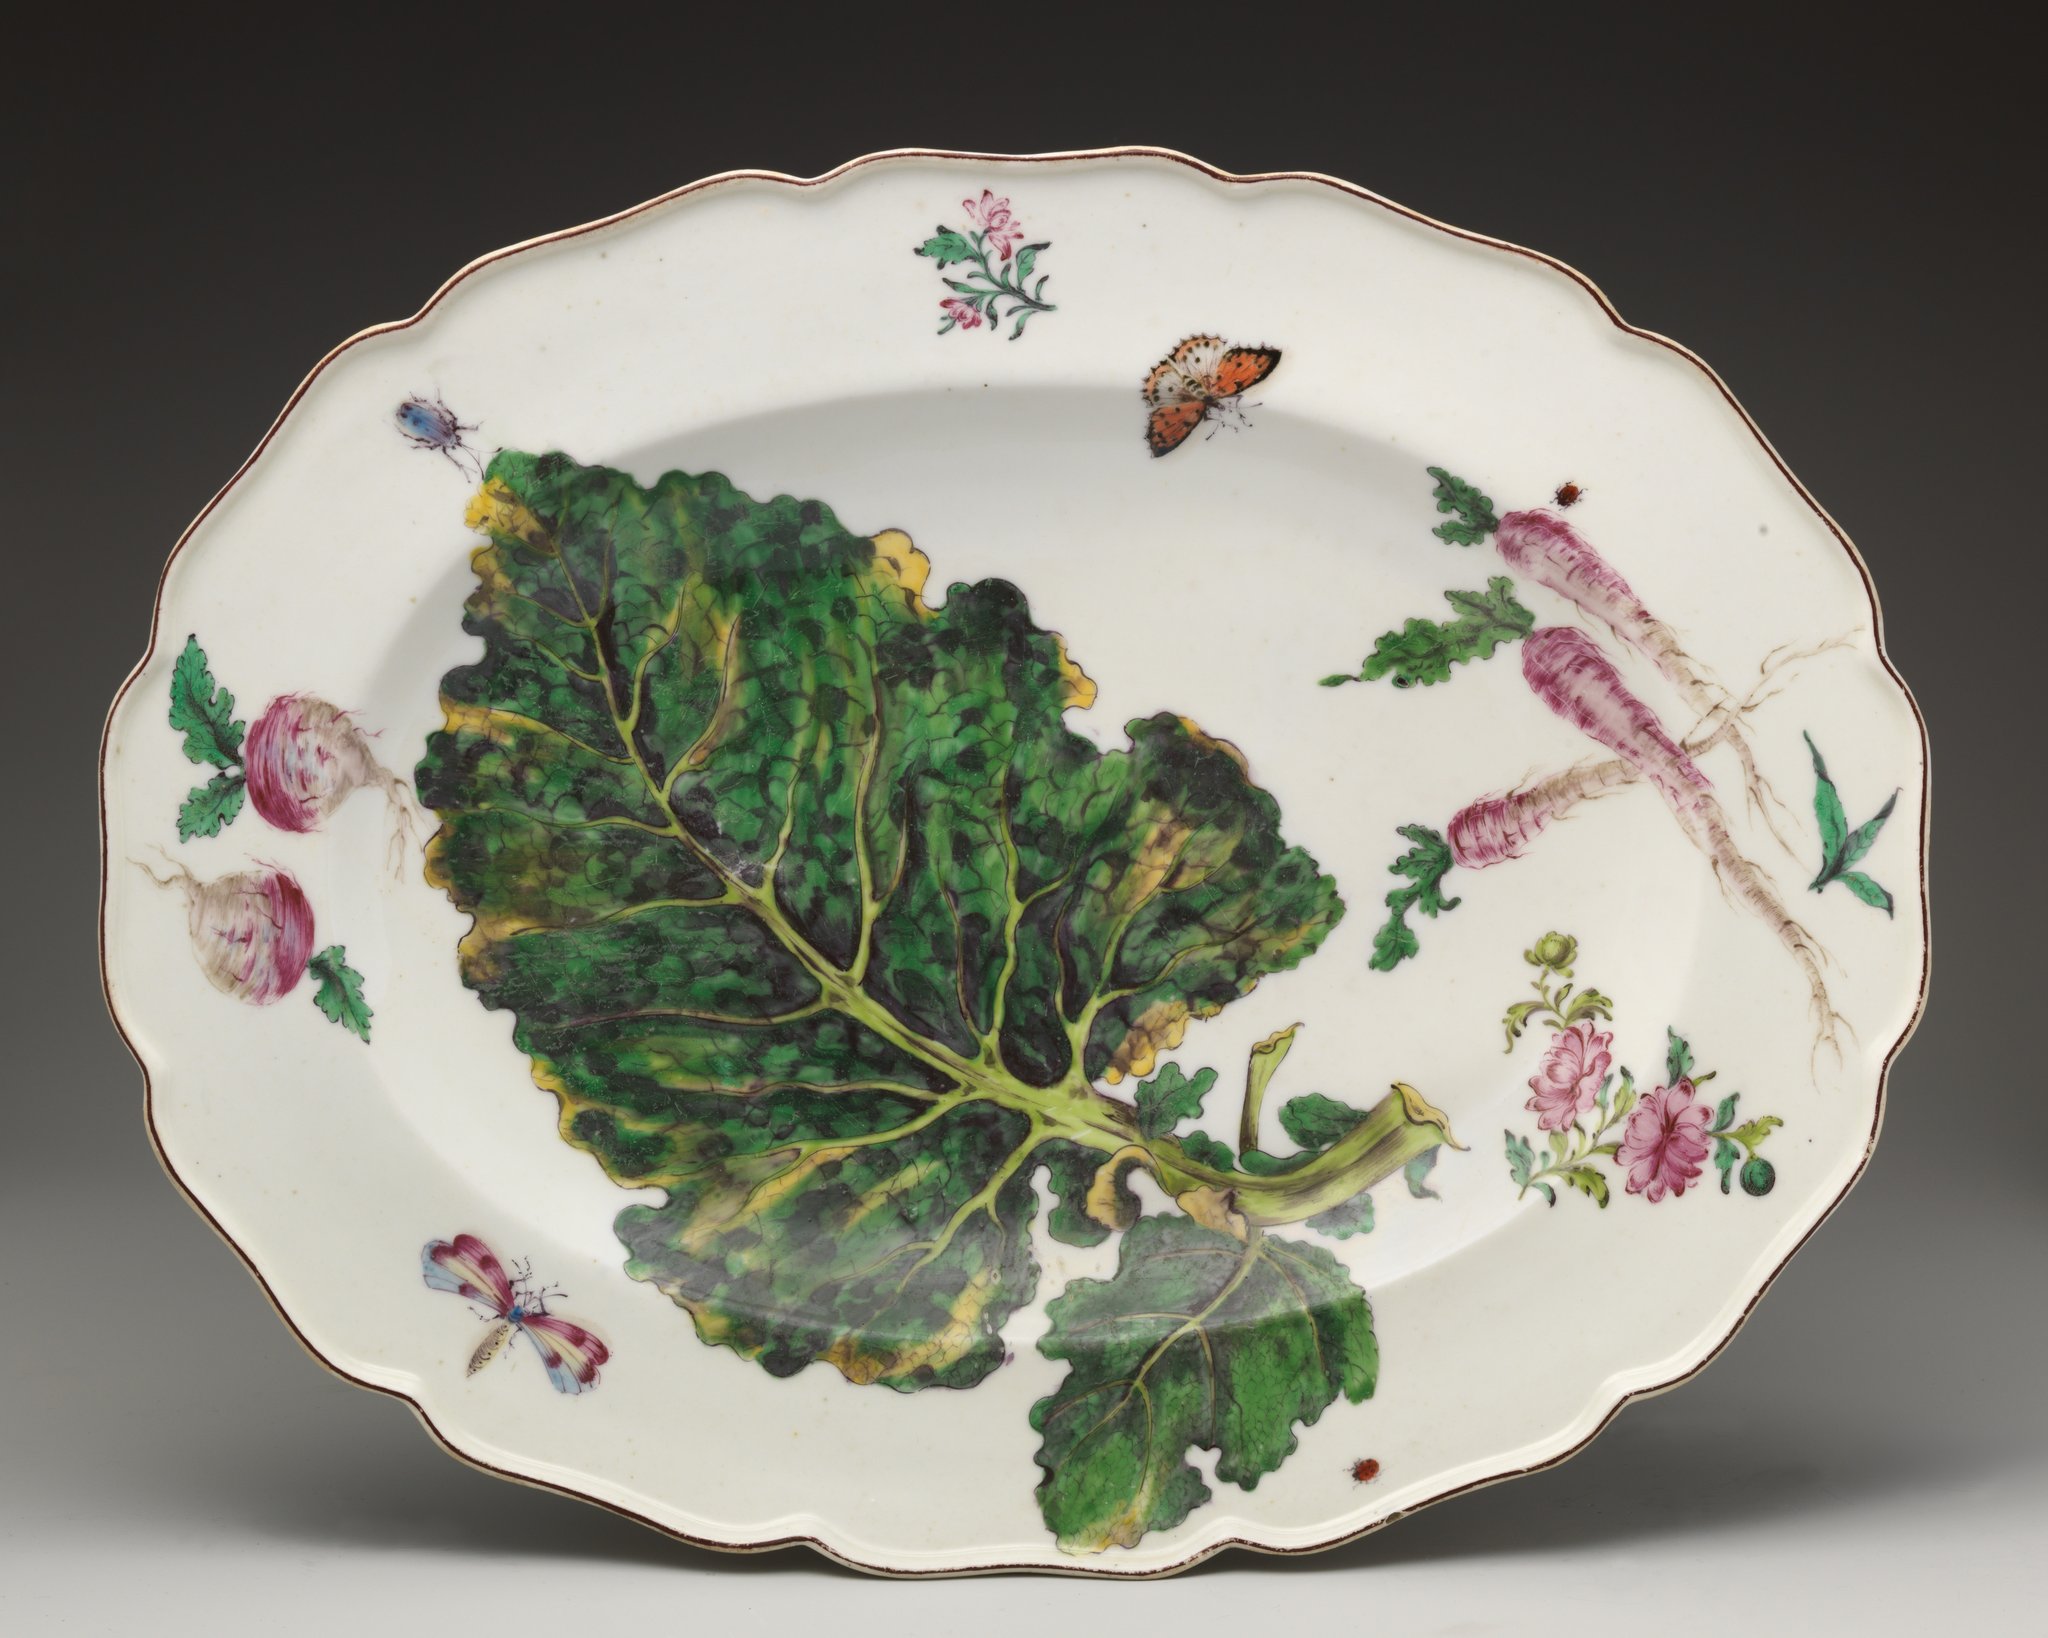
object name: platter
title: Botanical oval platter with turnip leaf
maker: chelsea porcelain manufactory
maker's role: factory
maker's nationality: british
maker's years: 1744-1784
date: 1755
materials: enamel, soft paste porcelain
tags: vegetables,insects,butterflies